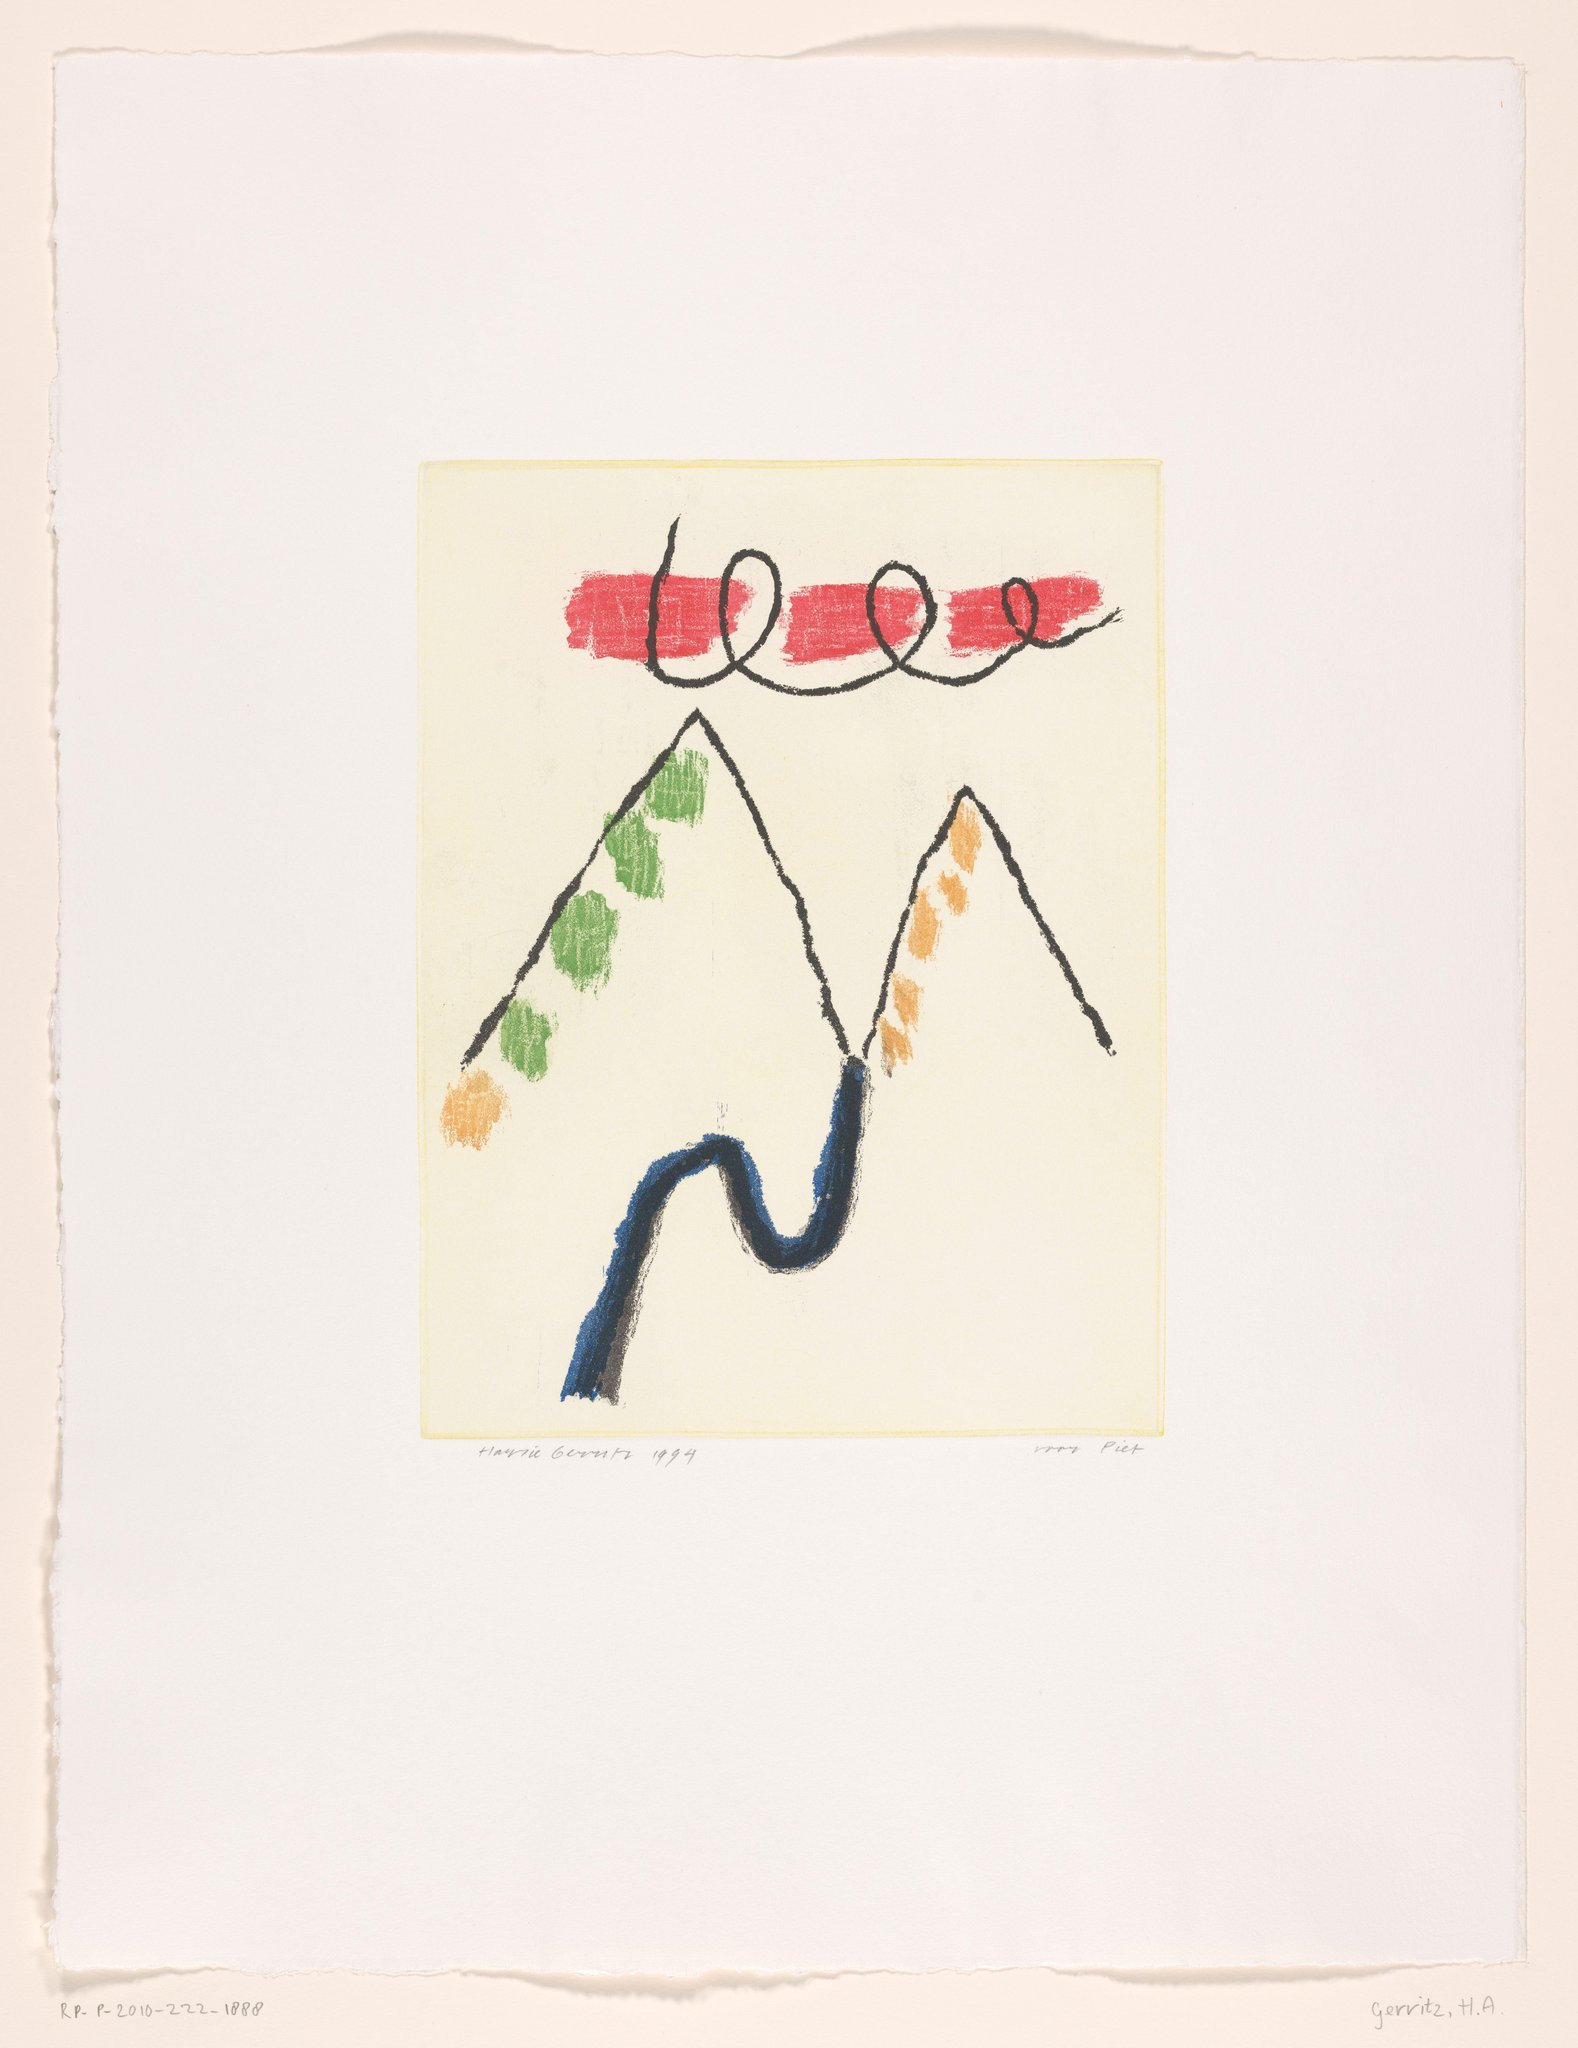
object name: print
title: Bergen en rivier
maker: harrie a. gerritz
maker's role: draughtsman, painter, print maker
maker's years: 1940-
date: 1994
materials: paper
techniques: aquatint, intaglio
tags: river, mountains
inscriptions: collector's mark: Lugt 2228, dedication: ‘voor Piet’, inscription: ‘PC’, watermark:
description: Schematische weergave van puntige bergtoppen met daartussen een meanderende rivier, tegen een gele achtergrond.